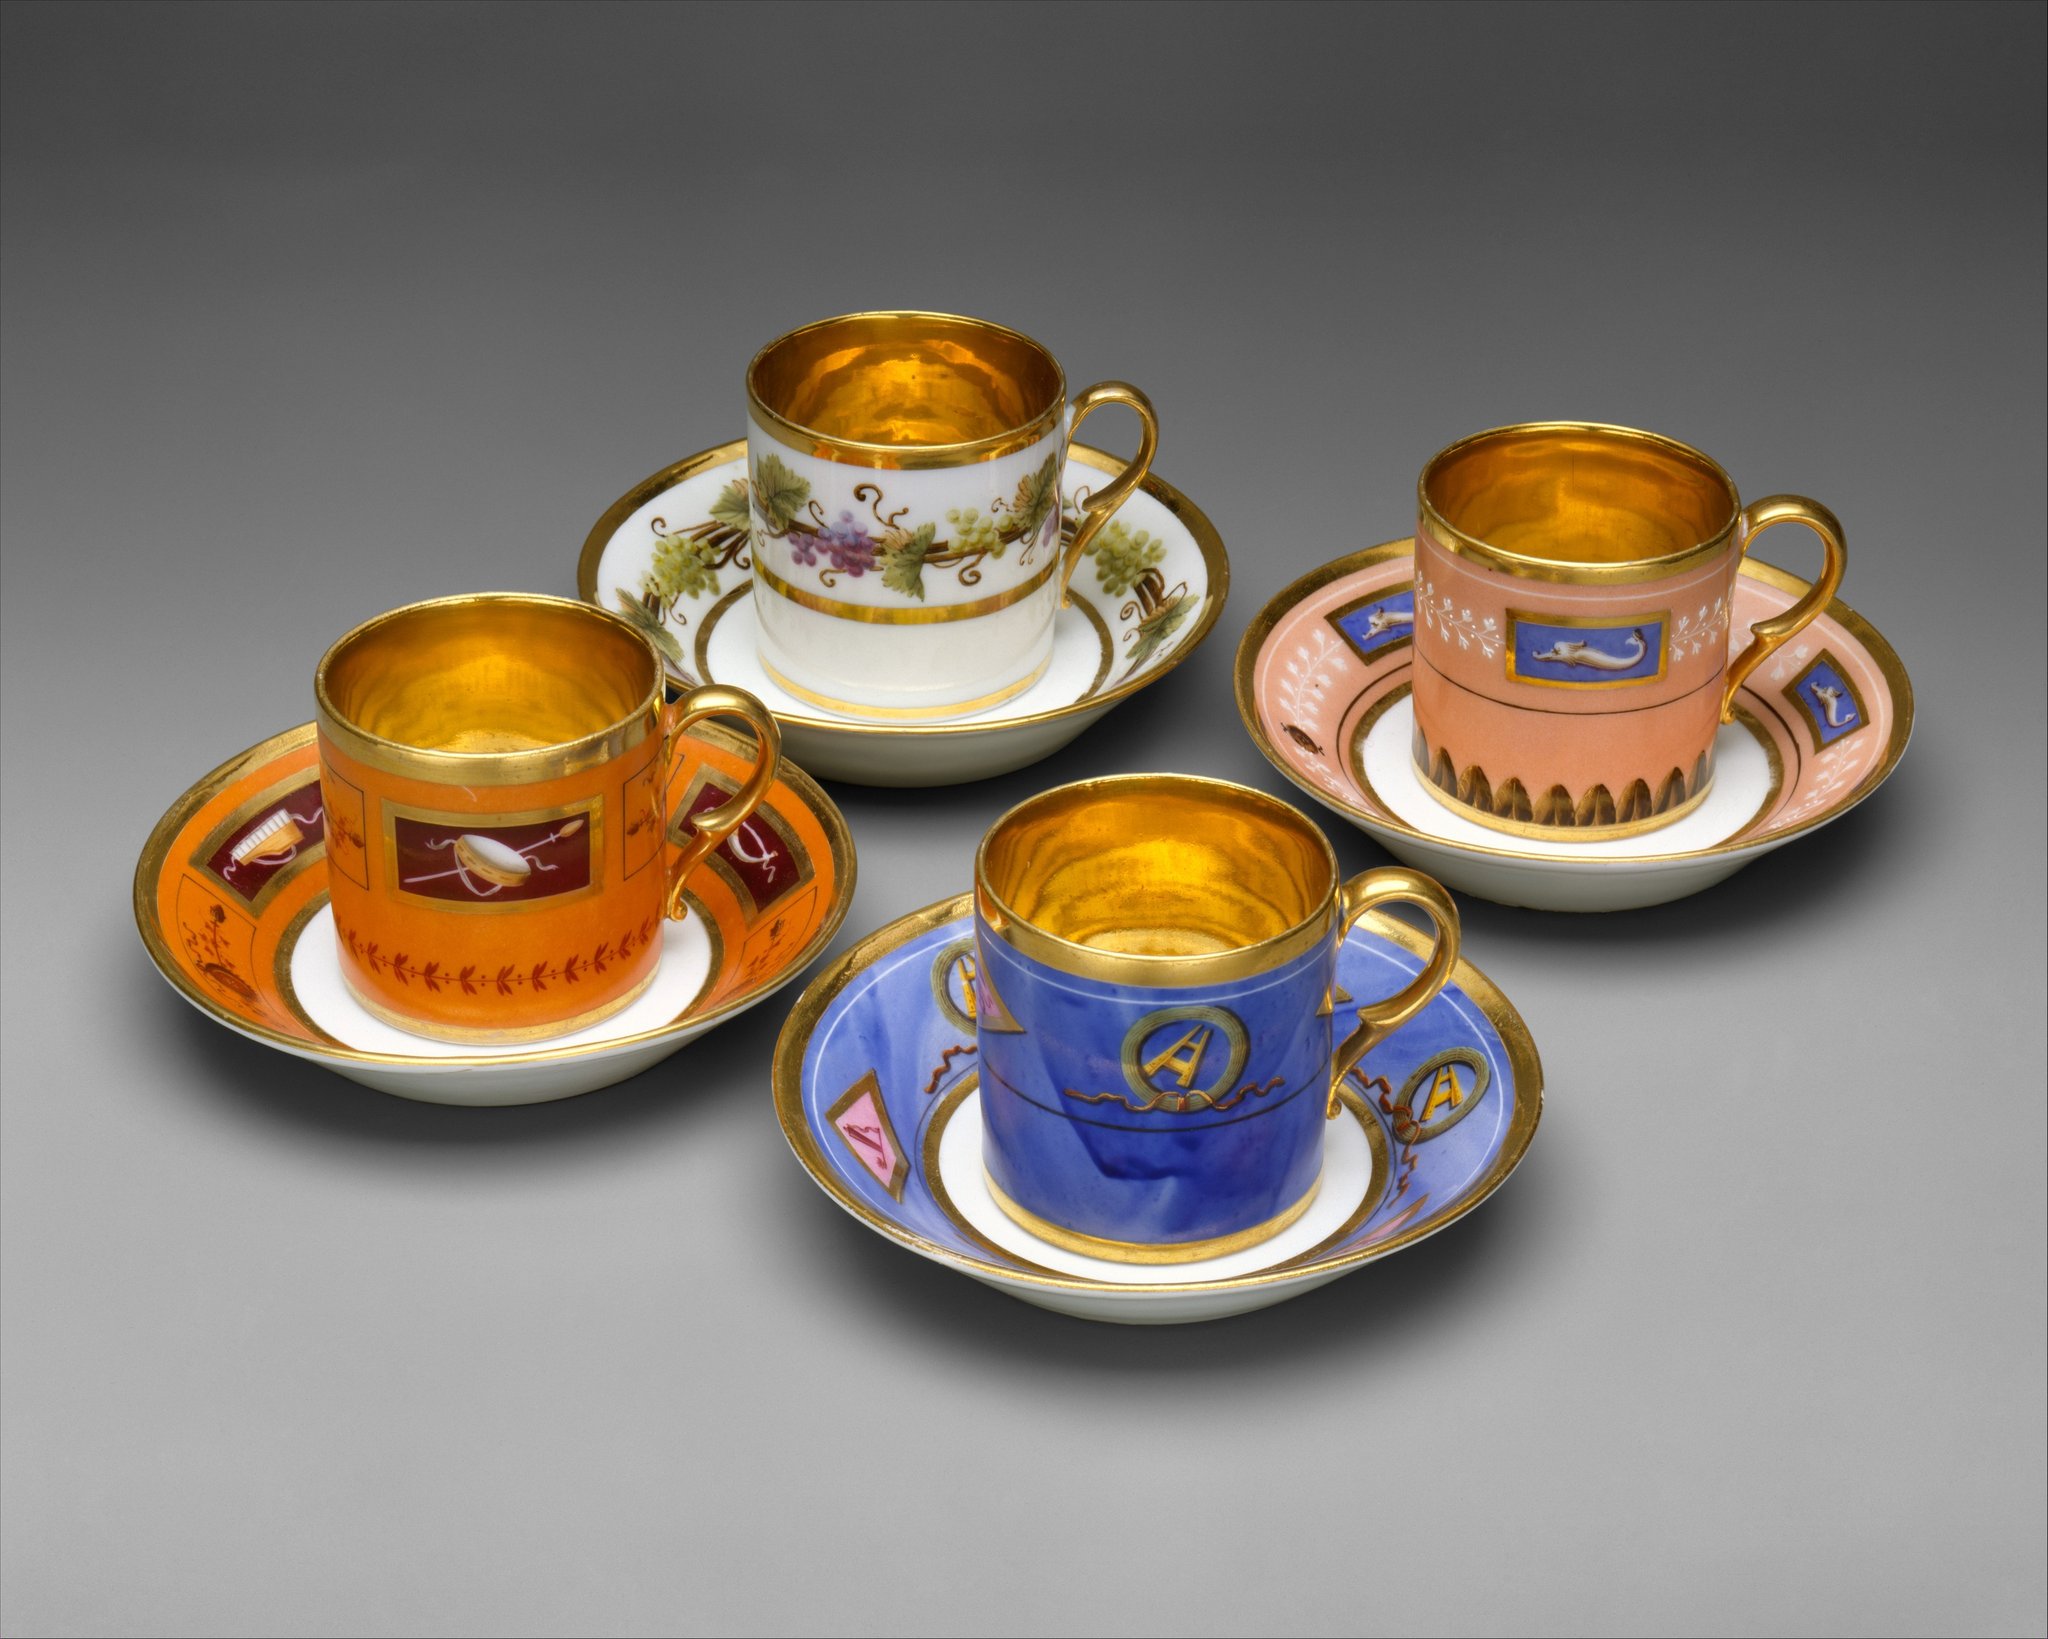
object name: cup and saucer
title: Cups and saucers (3)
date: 1800-1810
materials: hard paste porcelain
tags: swans,insignia